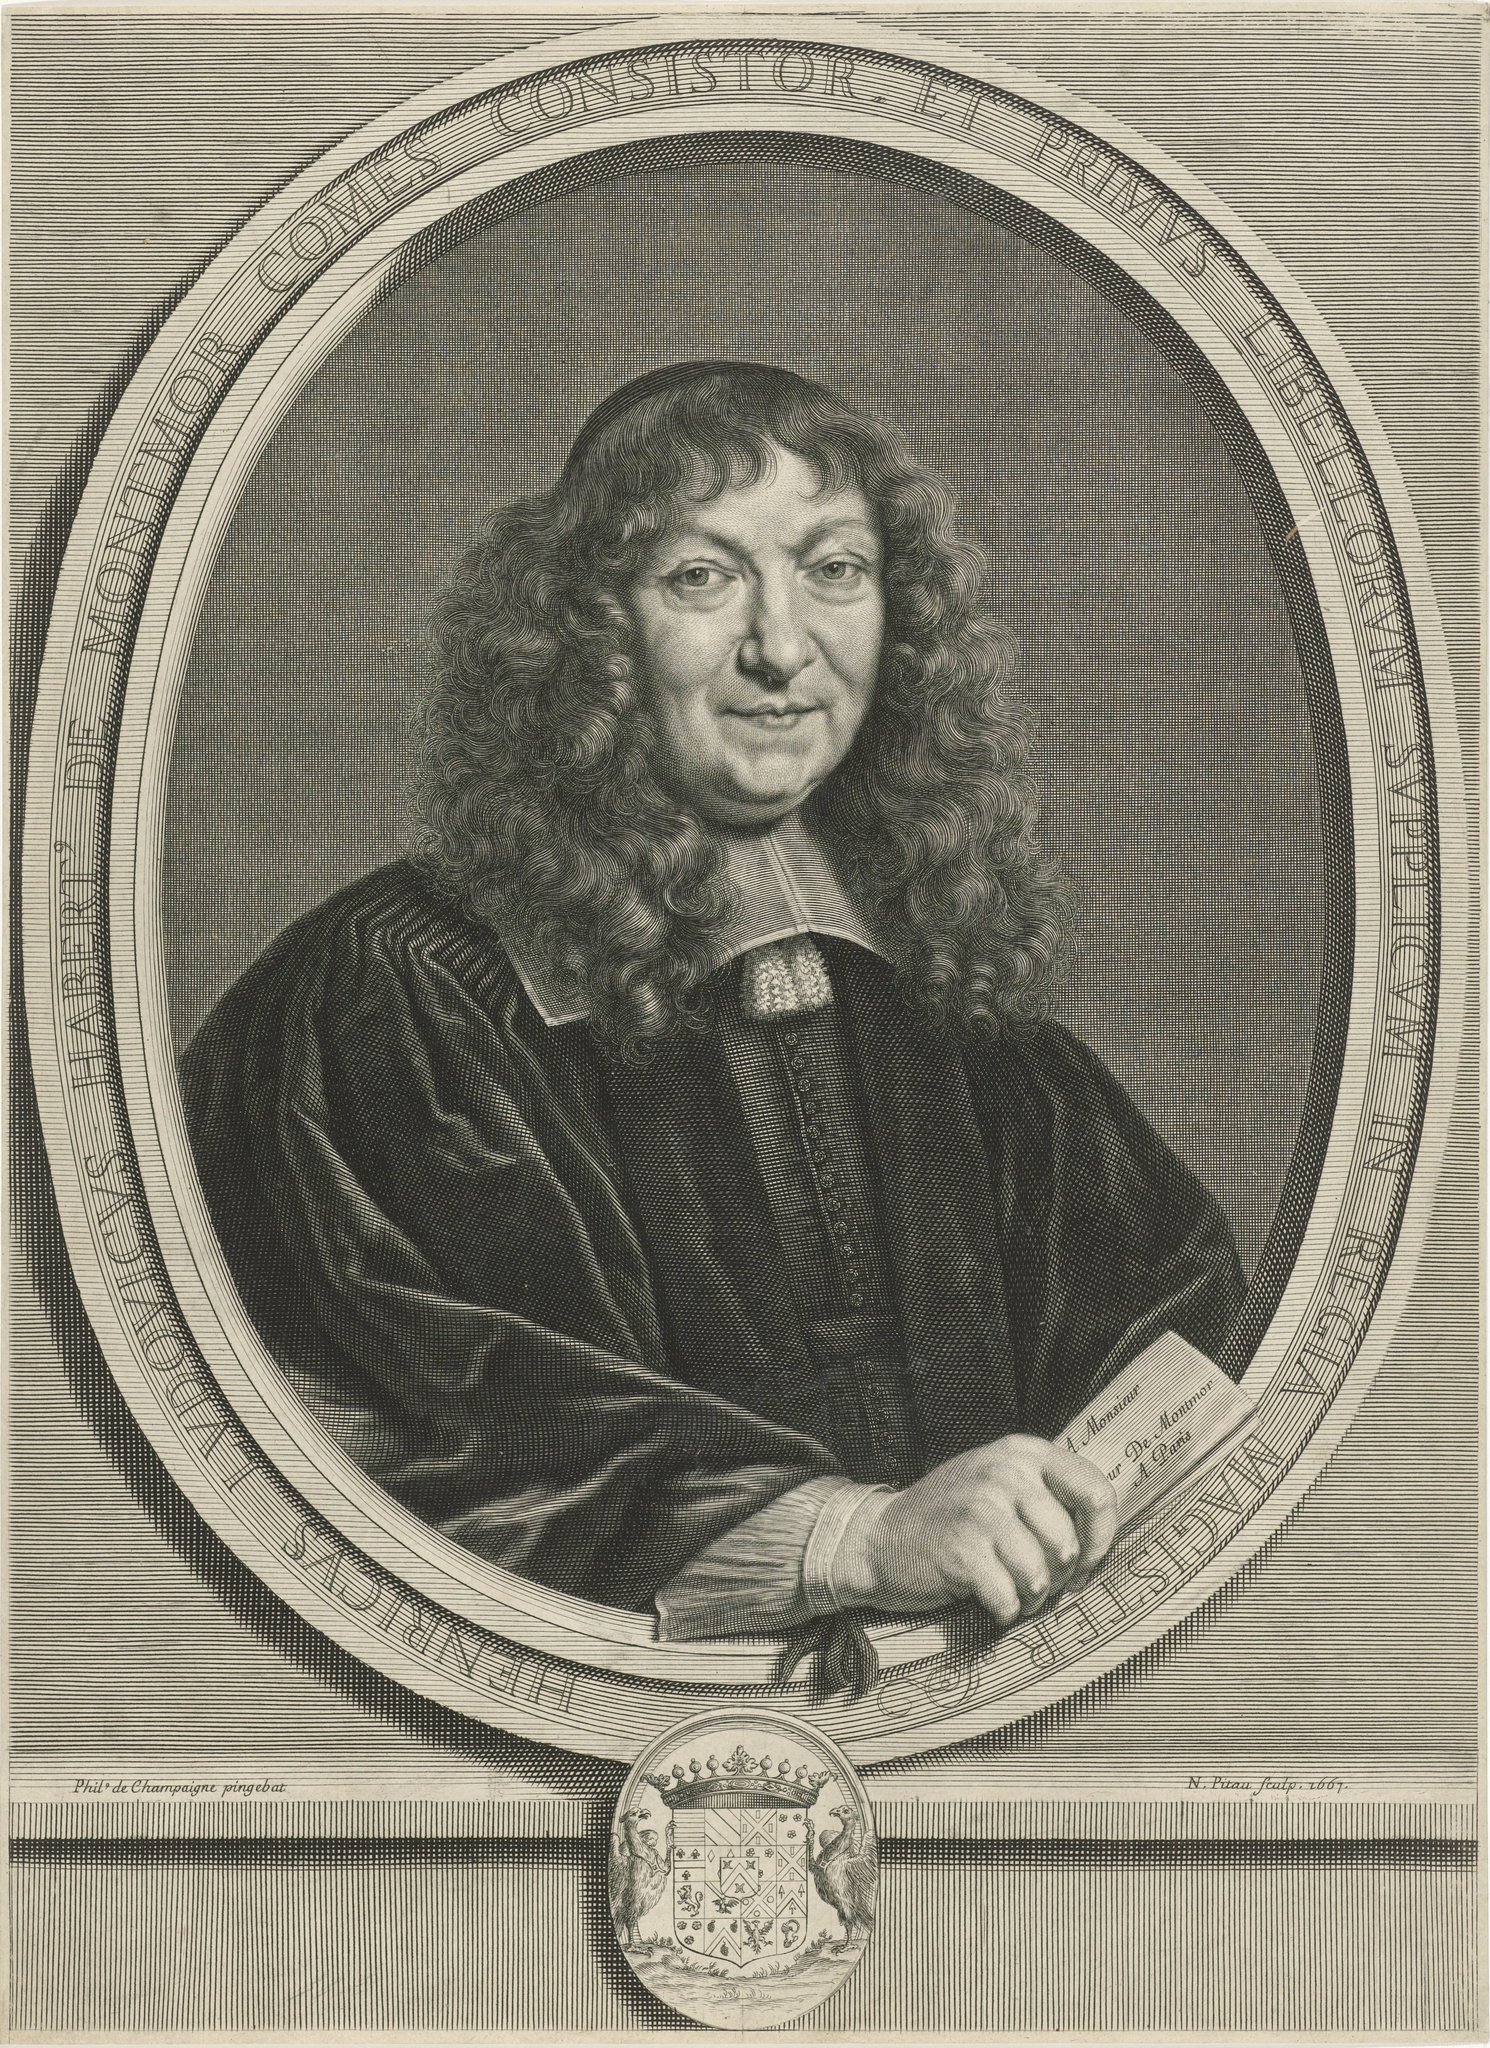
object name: print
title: Portret van Henri Louis Habert de Montmor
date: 1667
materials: paper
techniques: engraving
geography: paris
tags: paris, henri louis habert de montmor, letter, envelope, armorial bearing, heraldry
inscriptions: collector's mark: Lugt 2228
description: Portret van Henri Louis Habert de Montmor, een Franse geleerde. Hij houdt een brief in de hand. Op de piëdestal zijn wapenschild.